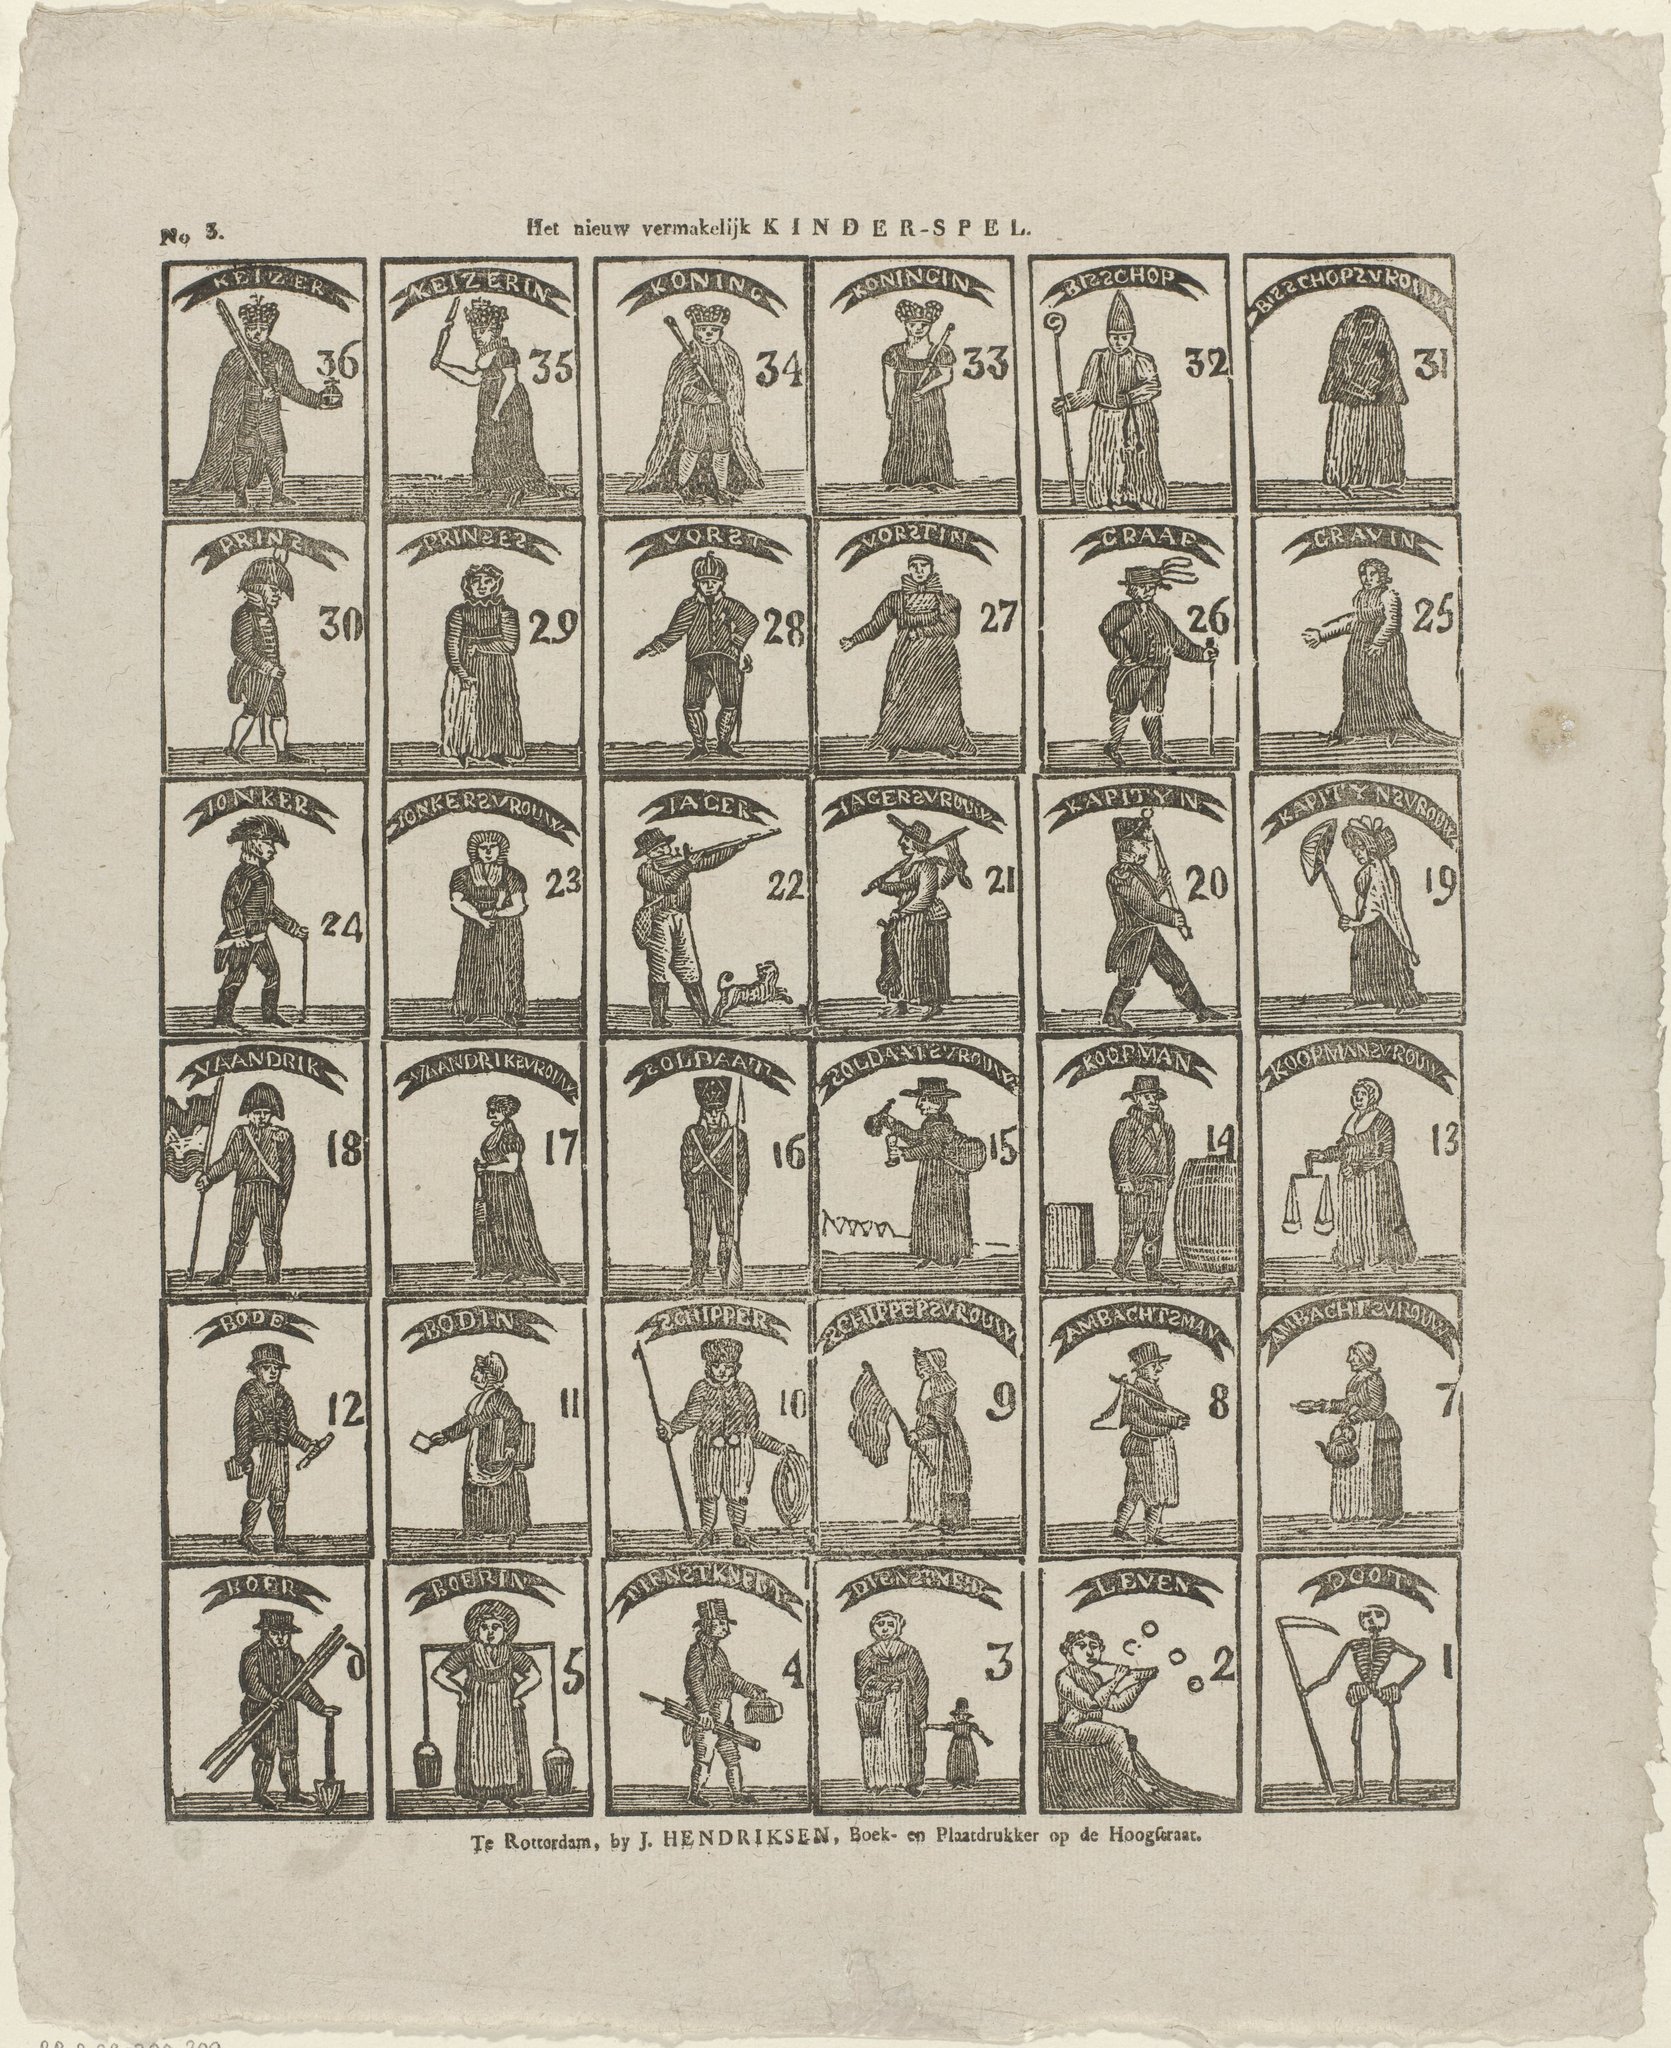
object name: popular print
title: Floskaartjes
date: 1781-1821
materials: paper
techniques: woodcut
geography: rotterdam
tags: symbols and personifications of death, social position, playing-cards, nobility and patriciate; chivalry, knighthood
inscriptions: collector's mark: Lugt 2760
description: Blad met 36 speelkaarten (floskaartjes) met voorstellingen van verschillende figuren. De afbeeldingen vormen achttien paren, aflopend genummerd van bovenaan links nummer 36 tot onderaan rechts nummer 1. Op de twee laagste nummers na tonen ze zeventien koppels, man en vrouw, met de man net één nummer hoger dan de vrouw, waarbij elk paar een beroep of een maatschappelijke positie voorstelt. Genummerd linksboven: No. 3.